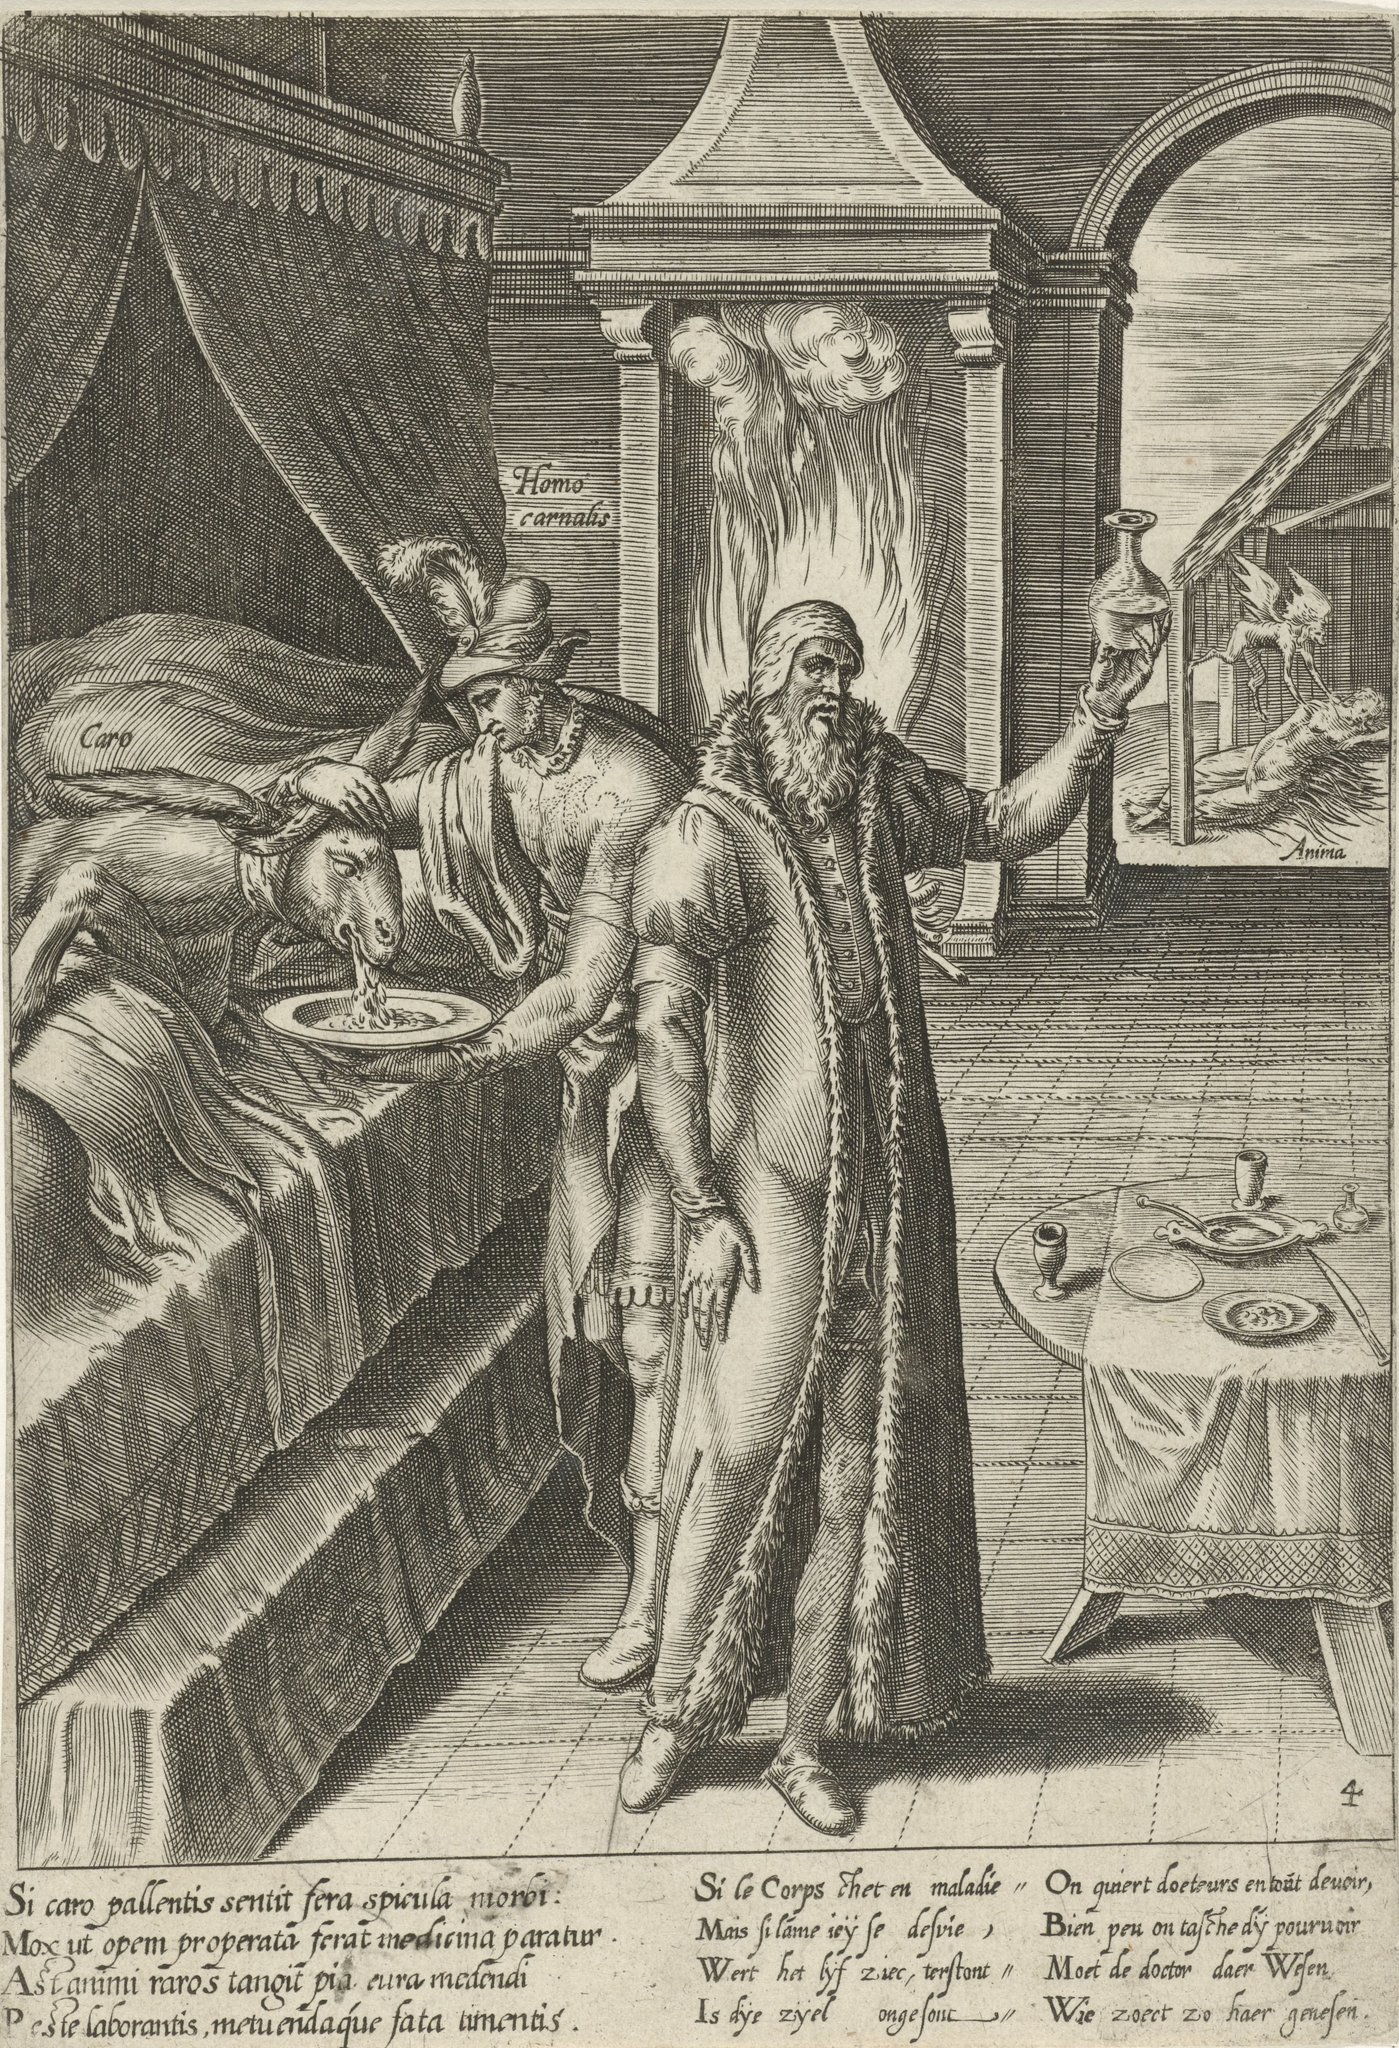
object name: print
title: Allegorieën over de zorg van de mens voor het lichaam en de verwaarlozing van de ziel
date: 1610-1676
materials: paper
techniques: engraving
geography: antwerp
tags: sick-bed, deathbed, physician, doctor, examination of urine, nursing, tending the sick, spirit (or soul) versus body, tort; legal abuse; judicial murder (+ abuse of legal power), death struggle, inquiet death; fear of death, the soul during lifetime, ass, donkey (+ animals used symbolically), the soul going to its last destination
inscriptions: collector's mark: Lugt 2228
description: Een ezel ligt in zijn ziekbed en braakt. Hij staat symbool voor het zieke menselijk lichaam (Caro) en wordt door de personificatie van de lustvolle mens (Homo Carnalis) verpleegd. Een dokter is bij de patiënt geroepen en bekijkt een kruik met urine. Op de achtergrond sterft de personificatie van de door de mens verwaarloosde ziel (Anima) in een schuur. Een duivel vliegt boven haar en zal haar naar de hel begeleiden. Prent uit een serie van vier prenten over de zorg van de mens voor het lichaam en het negeren van de ziel. Elke prent met een onderschrift in het Latijn, Frans en Nederlands.